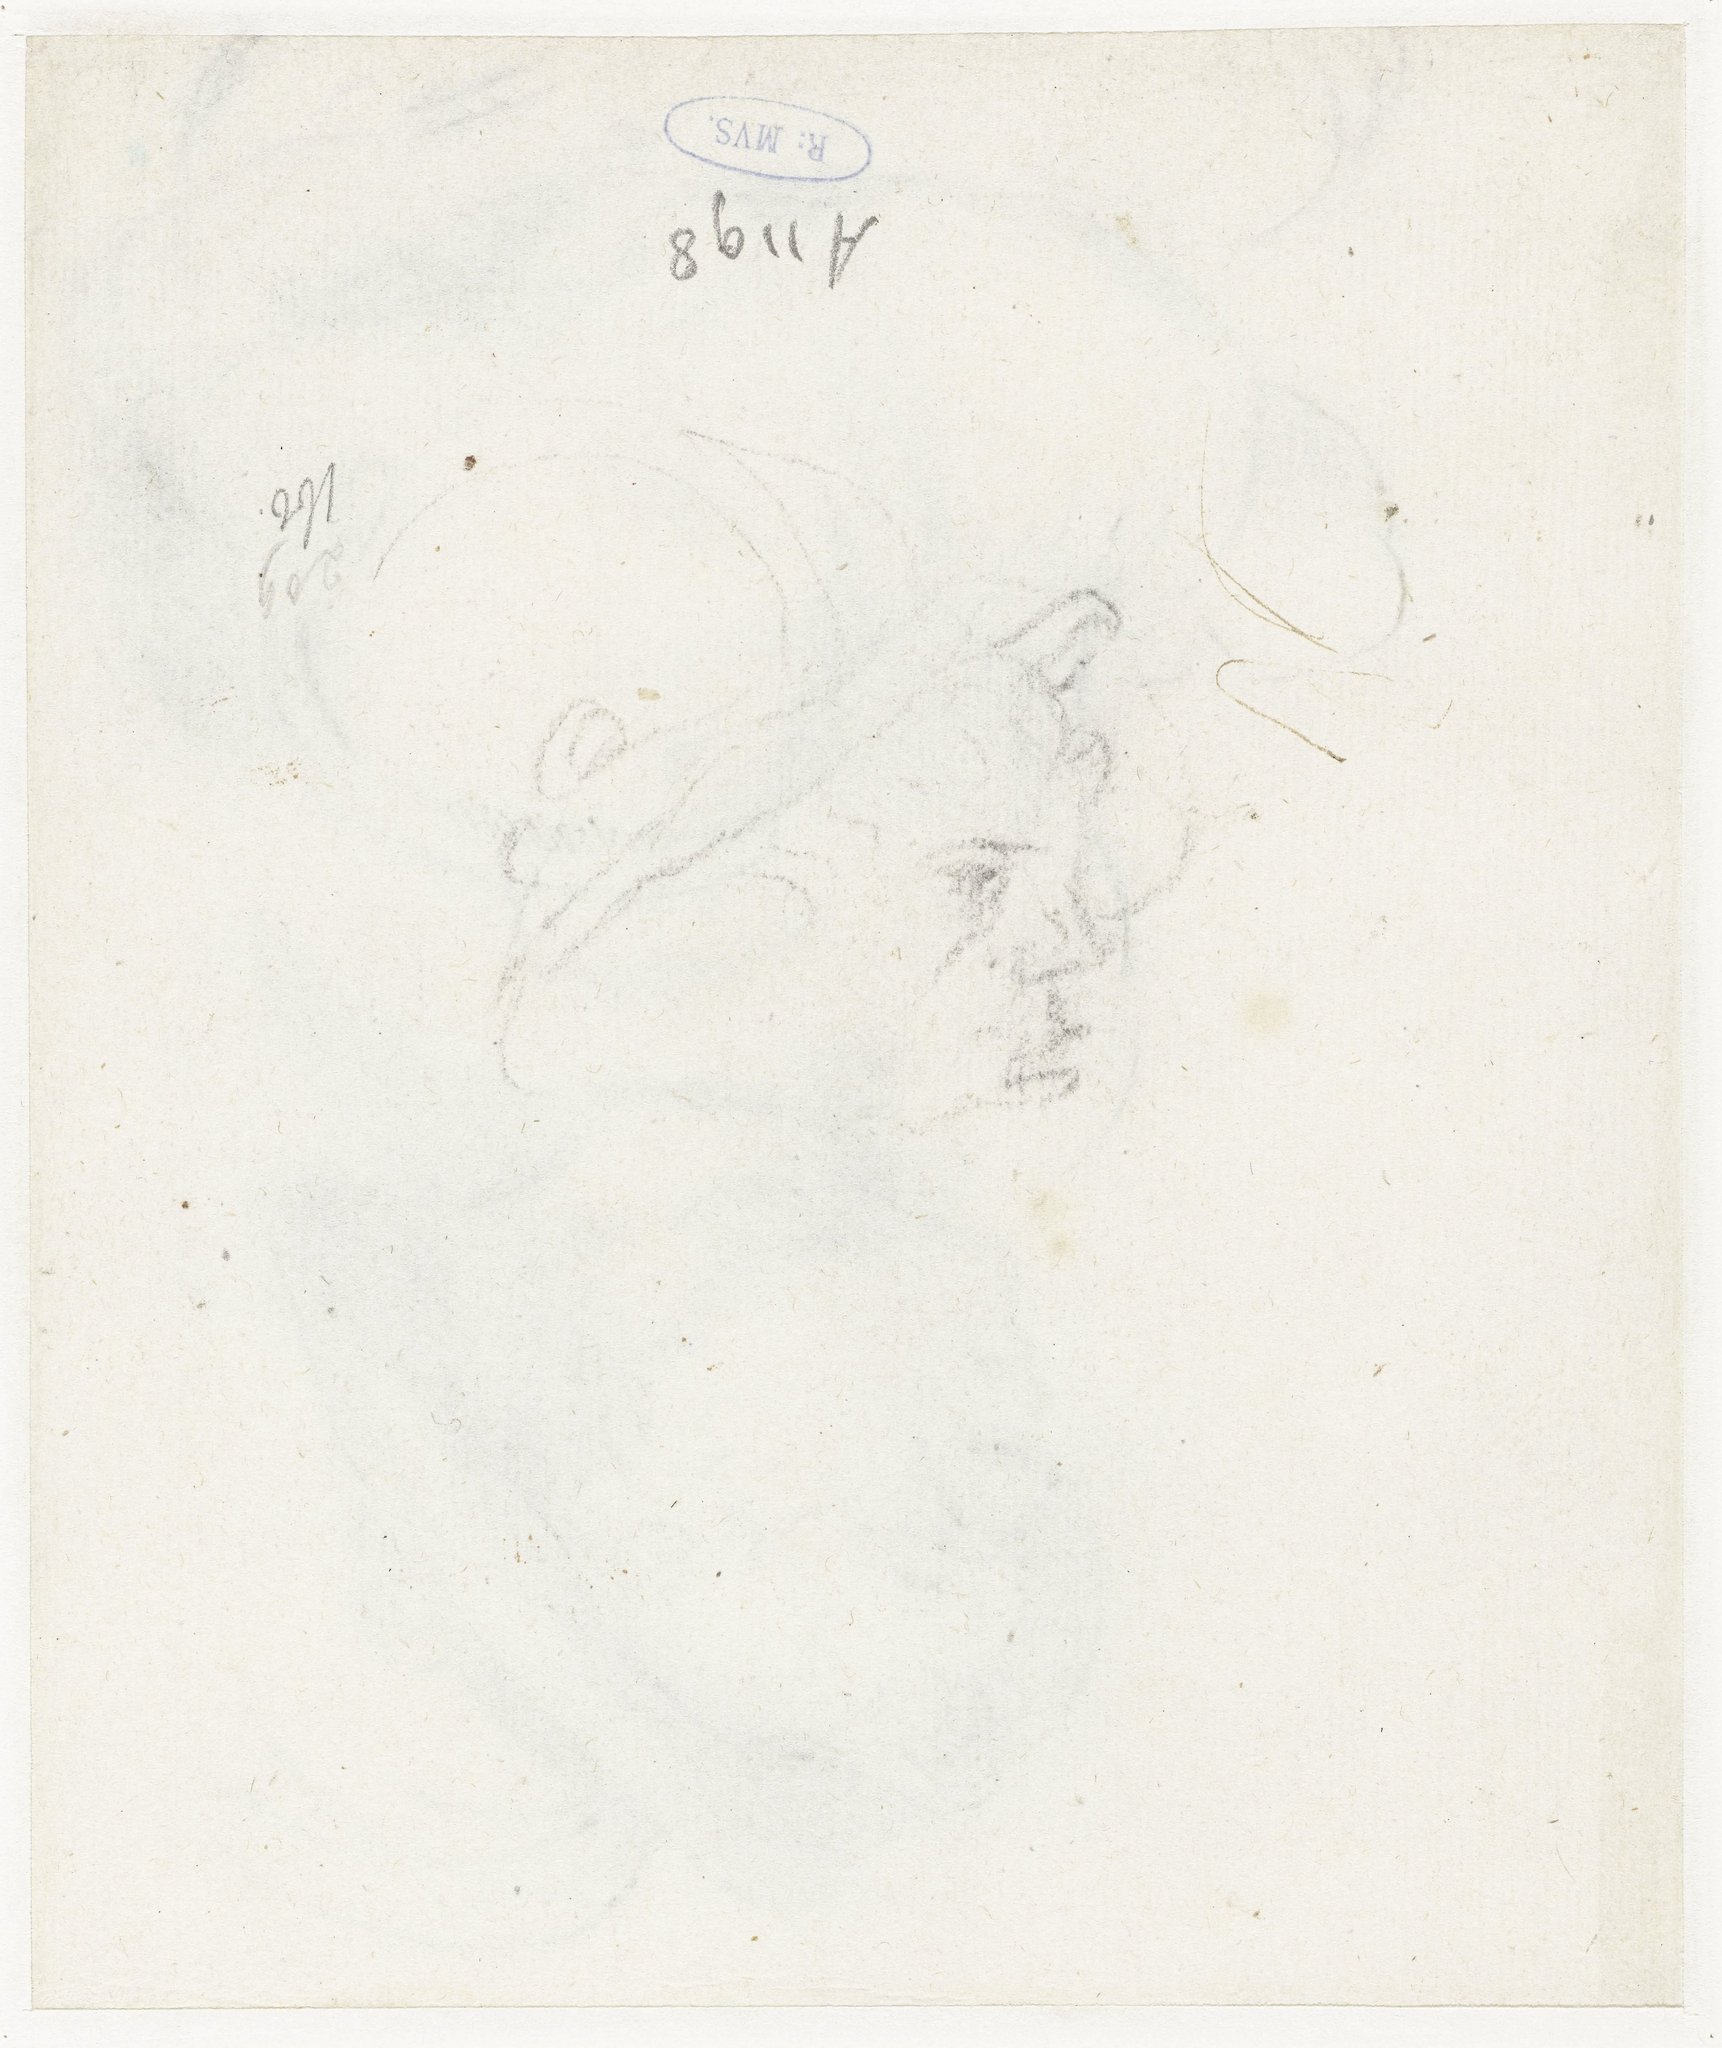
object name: drawing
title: Schets van het hoofd van een boer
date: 1656-1657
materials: chalk, paper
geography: zwolle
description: Schets van hetzelfde hoofd als op de voorzijde.